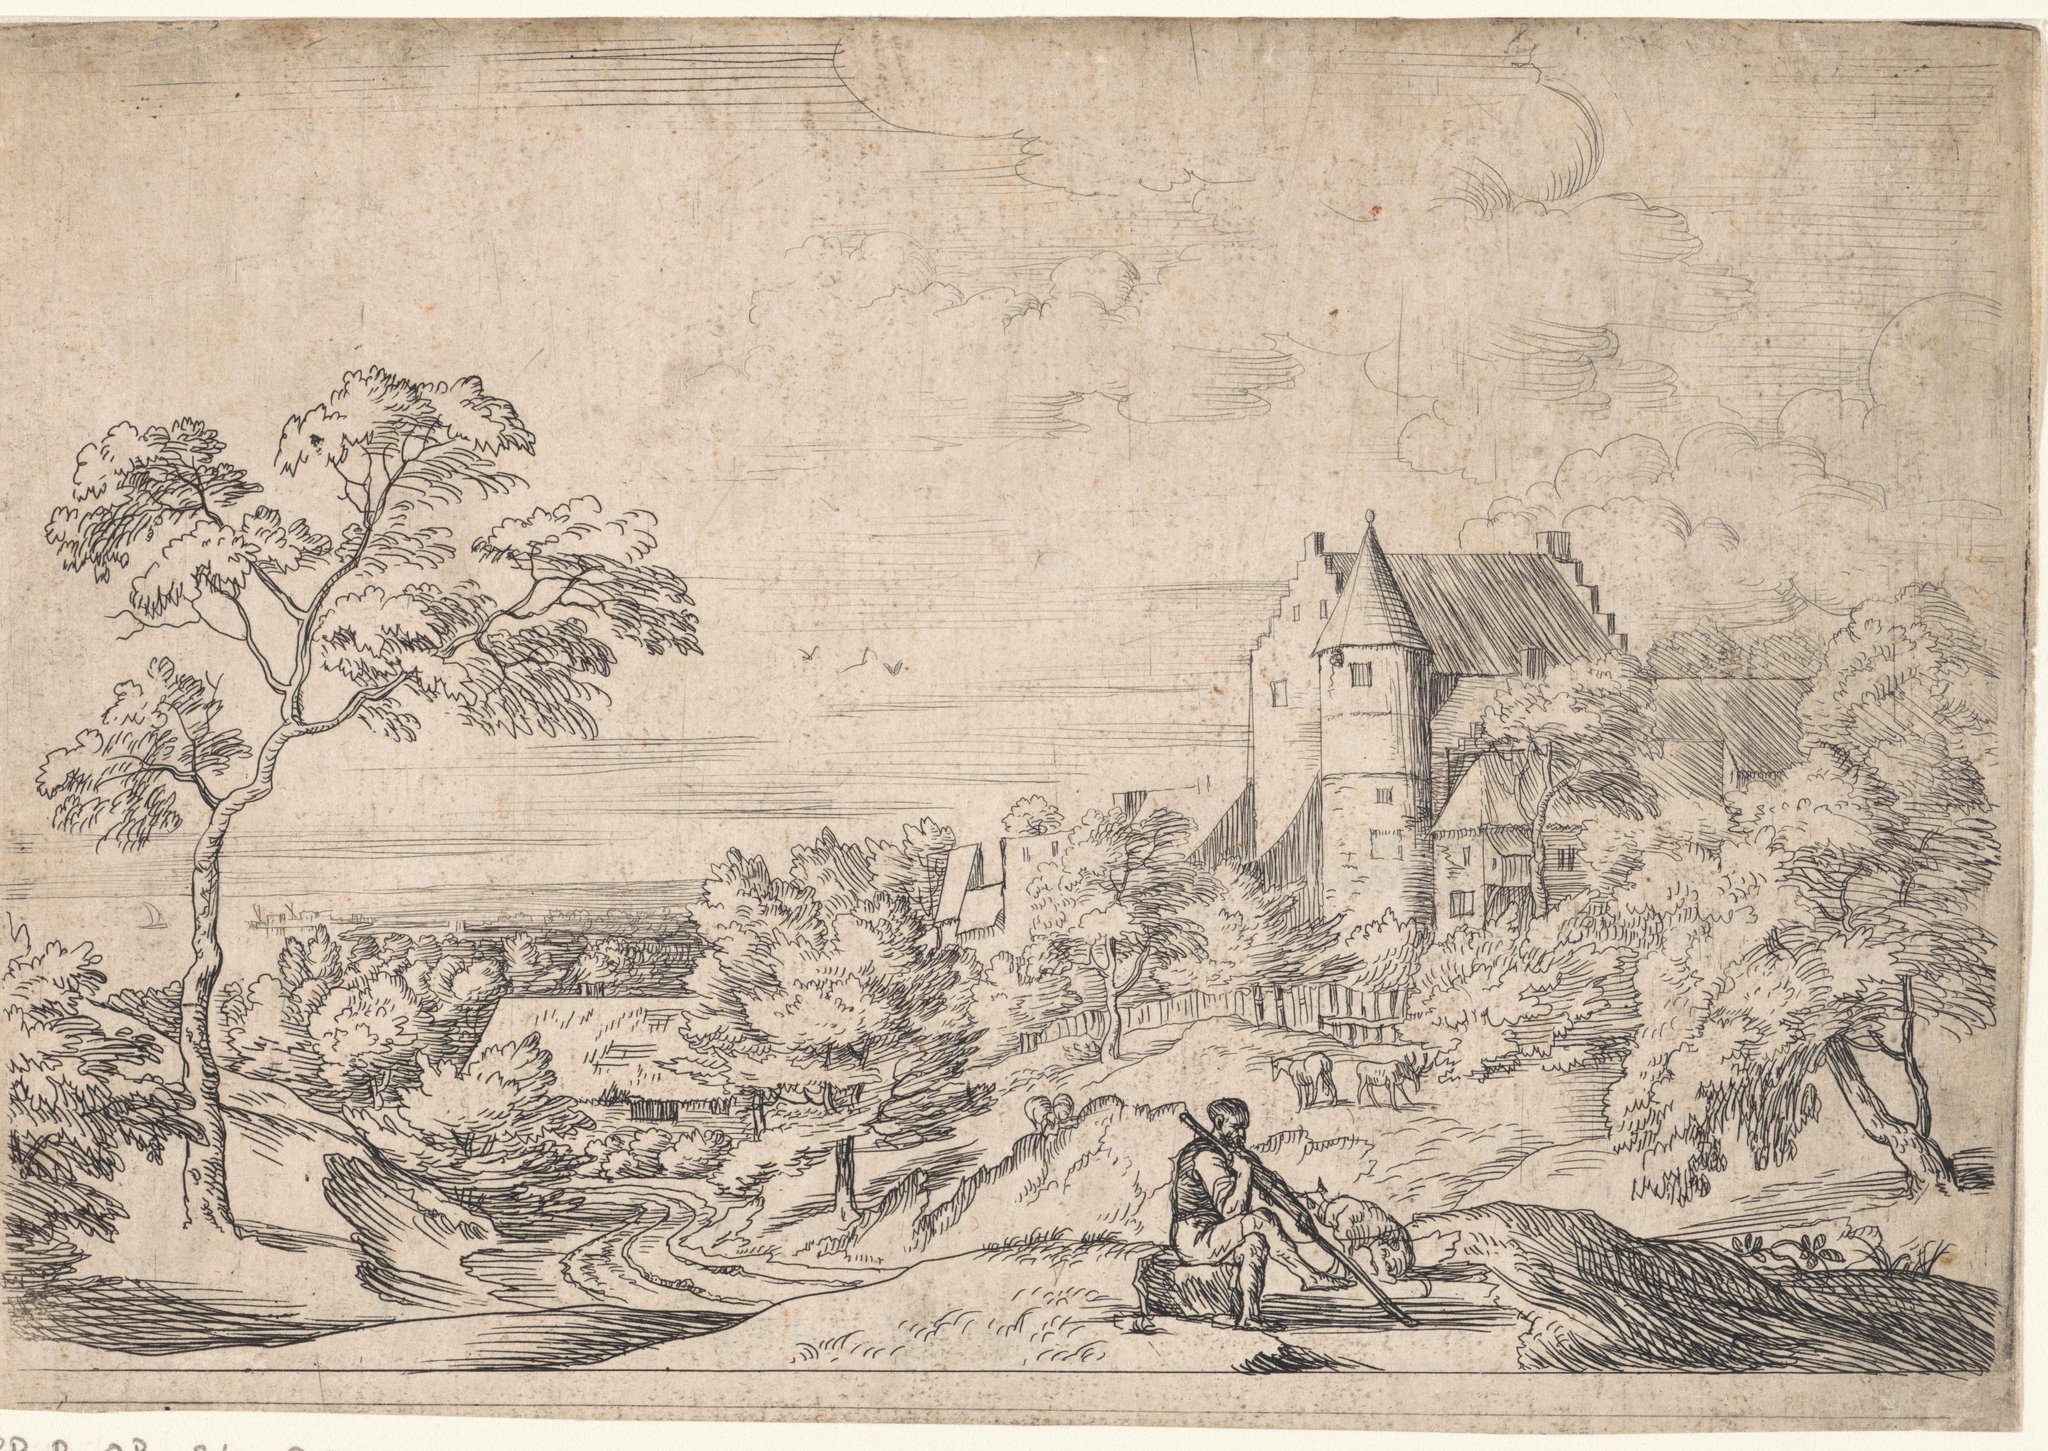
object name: print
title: Landschap met zittende man met hond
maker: frans wouters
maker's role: draughtsman, painter, print maker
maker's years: 1612-1659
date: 1649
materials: paper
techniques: etching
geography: antwerp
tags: landscapes in the temperate zone, landscape with tower or castle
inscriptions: collector's mark: Lugt 514, collector's mark: Lugt 2165